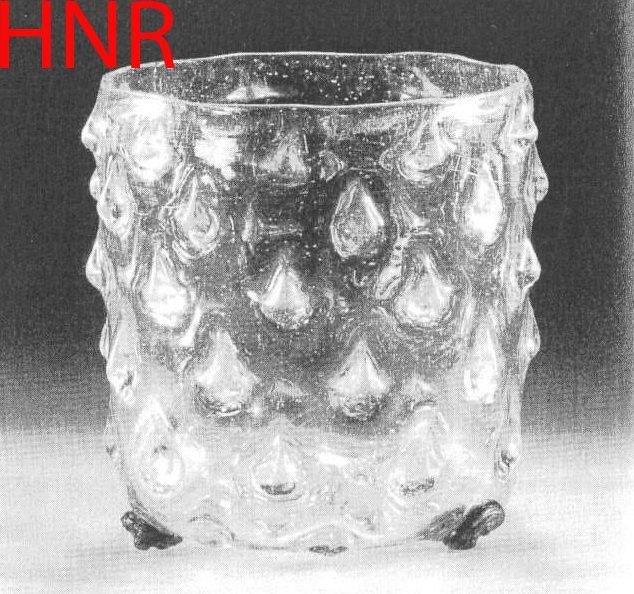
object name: knobbelbeker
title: Beaker with lozenge-shaped prunts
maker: Anonymous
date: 1600-1650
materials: glass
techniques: façon de venise, glassblowing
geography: netherlands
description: Glas à la façon de Venise. Ingestoken bodem. Cilindervormig lichaam in mal geblazen met ruitvormige knobbels, staat op drie blauwe pootjes in vorm van braamnoppen.